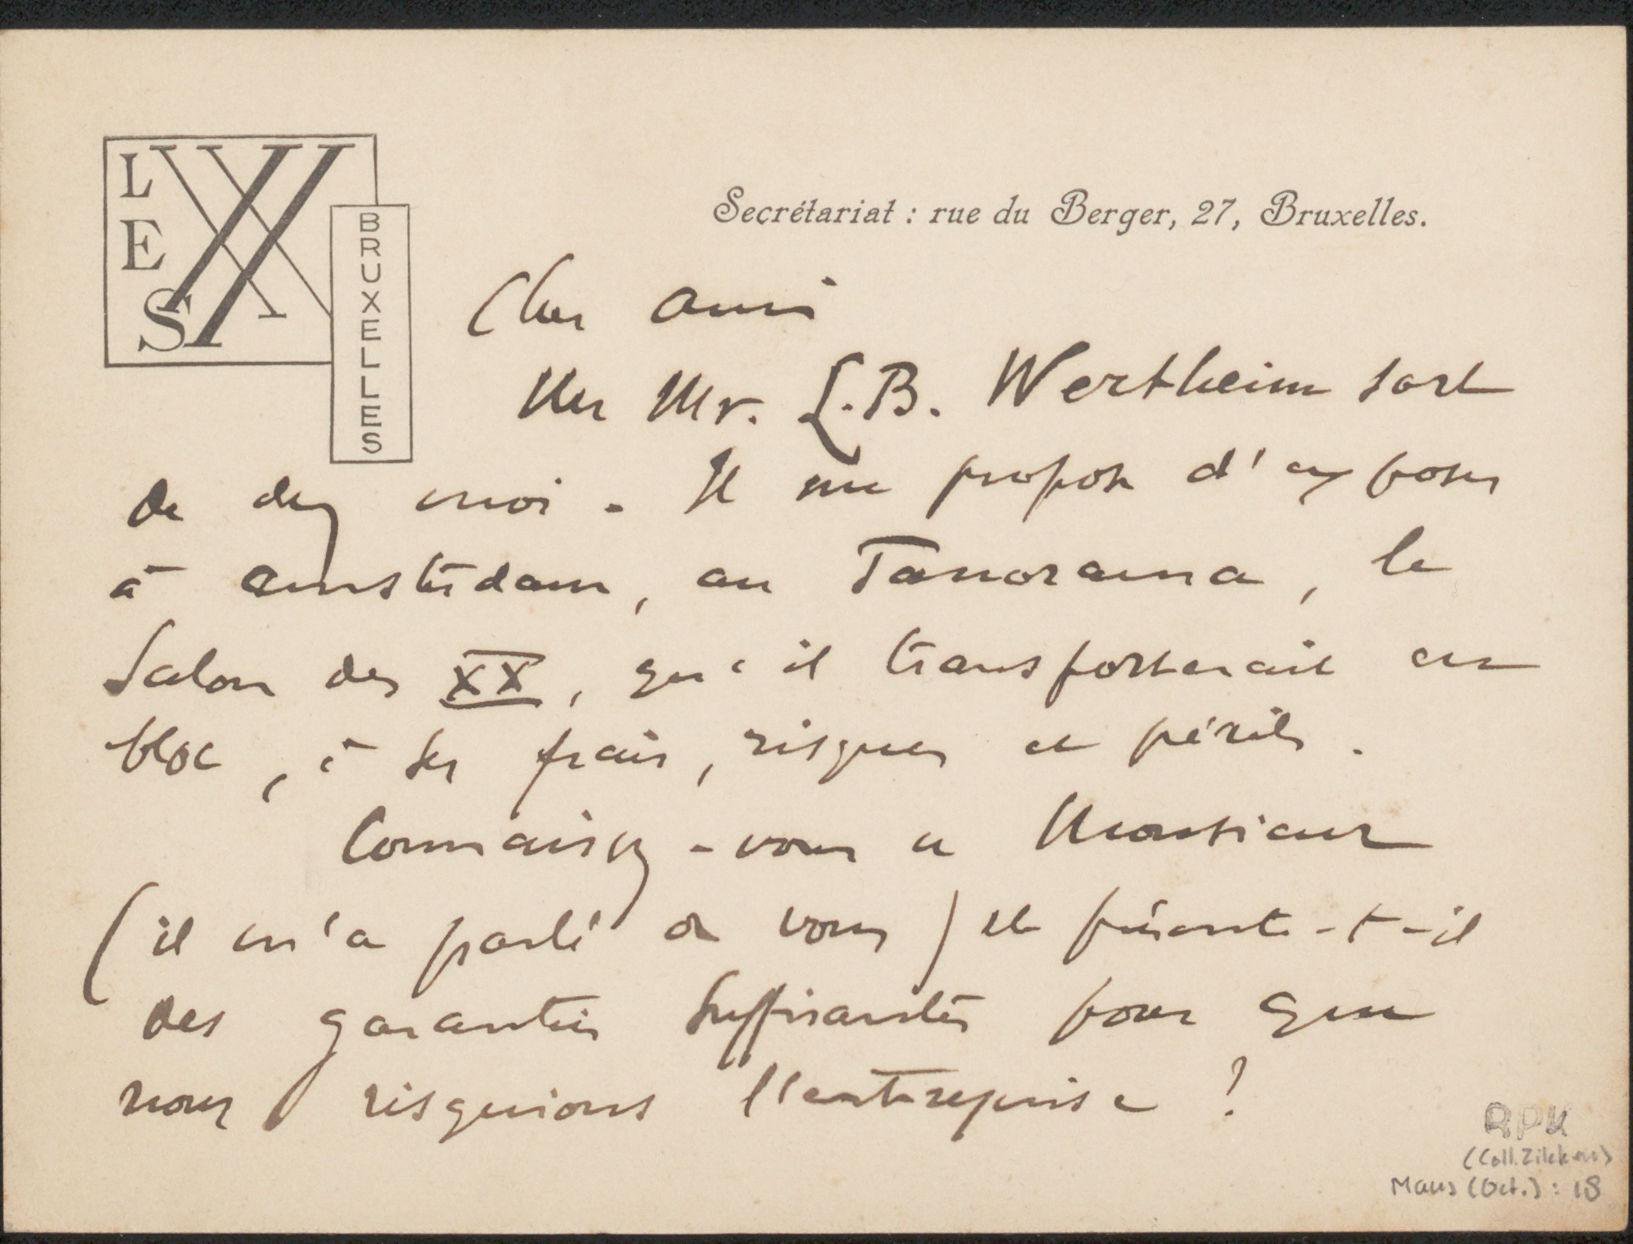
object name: letter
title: Brief aan Philip Zilcken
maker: octave maus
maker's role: painter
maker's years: 1856-1919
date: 1888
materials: cardboard, ink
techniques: pen, printing, writing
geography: brussels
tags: the hague, painter, draughtsman, philip zilcken, exhibition ~ art, amsterdam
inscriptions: collector's mark: ‘RPK’